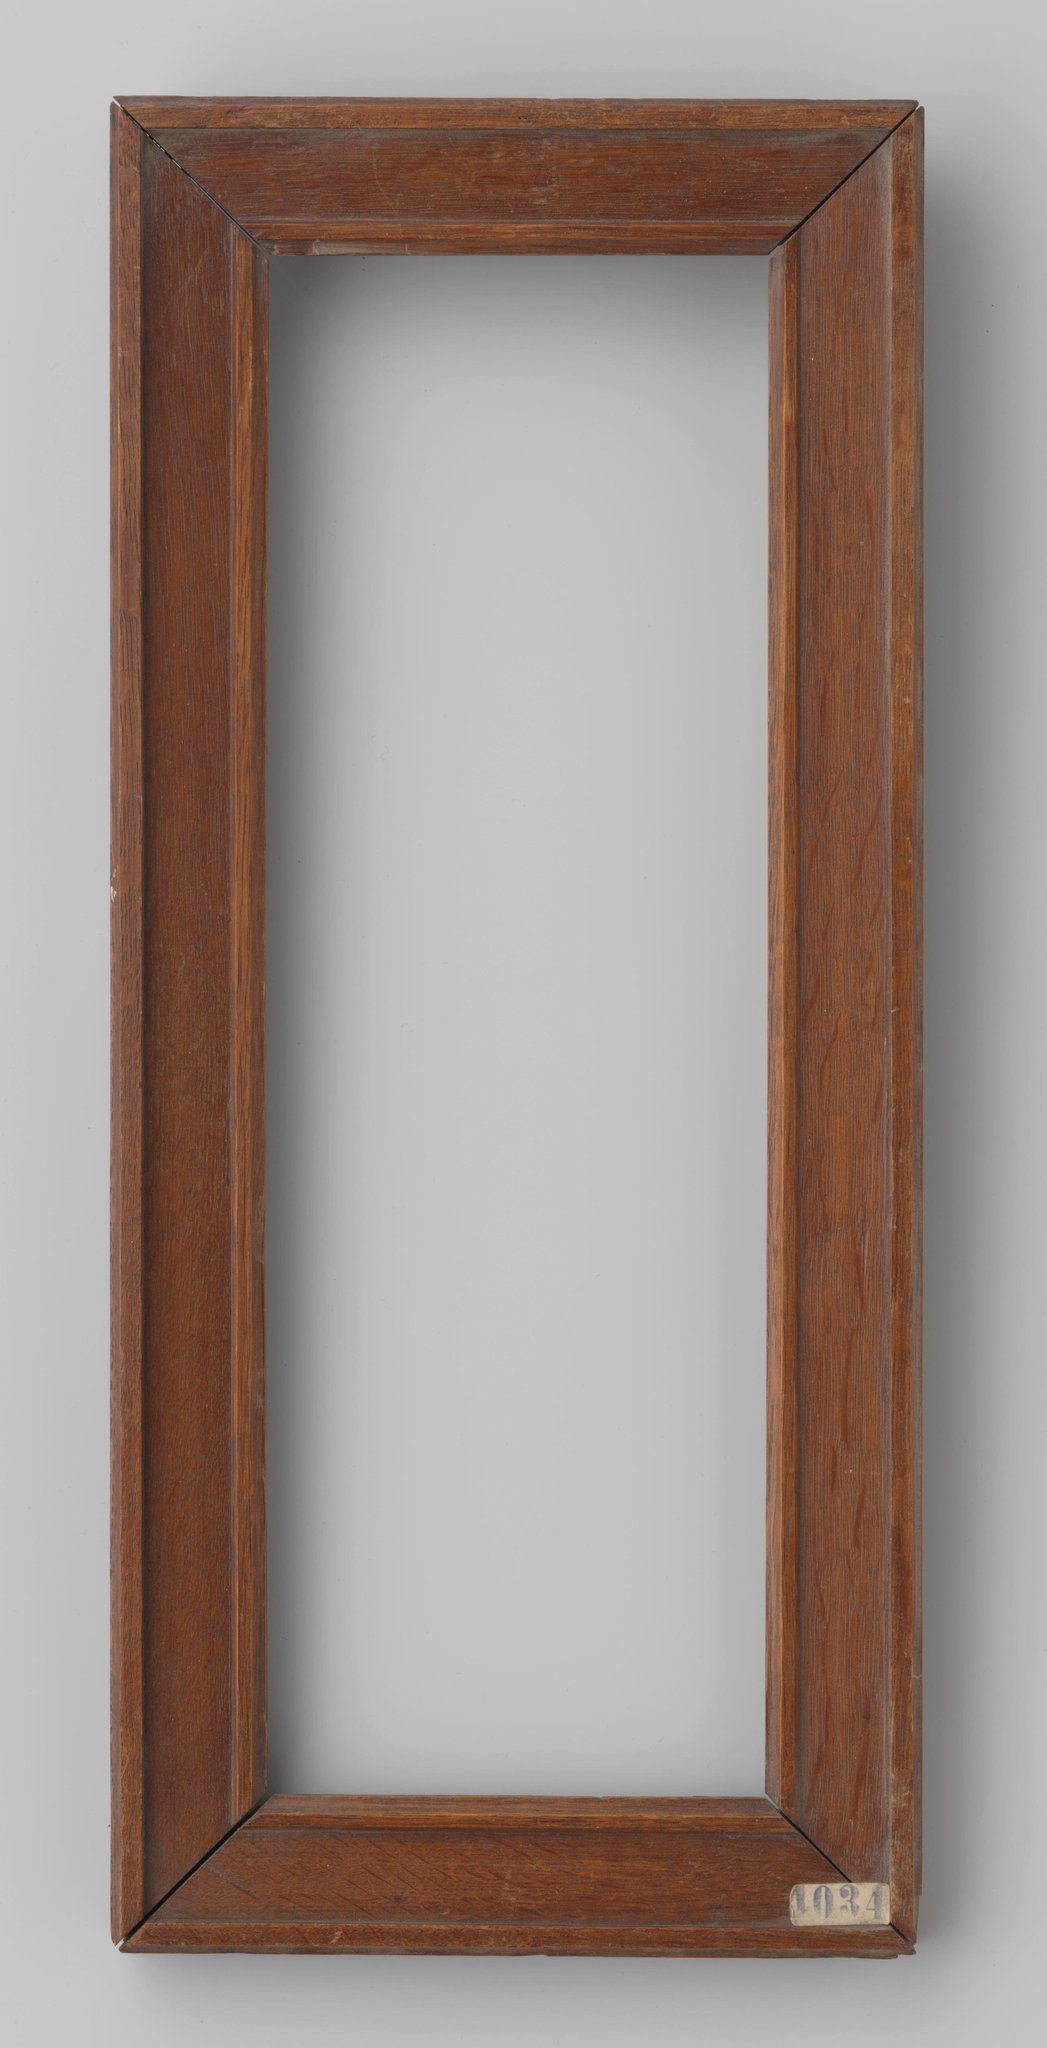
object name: frame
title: Lijst van tegeltableau beschilderd met kraanvogels en akeleien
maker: bert nienhuis (i)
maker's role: designer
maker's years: 1873-1960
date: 1896-1901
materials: wood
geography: amsterdam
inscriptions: monogram: ‘LN’, mark: ‘Boch Frères, La Louvière, A.’